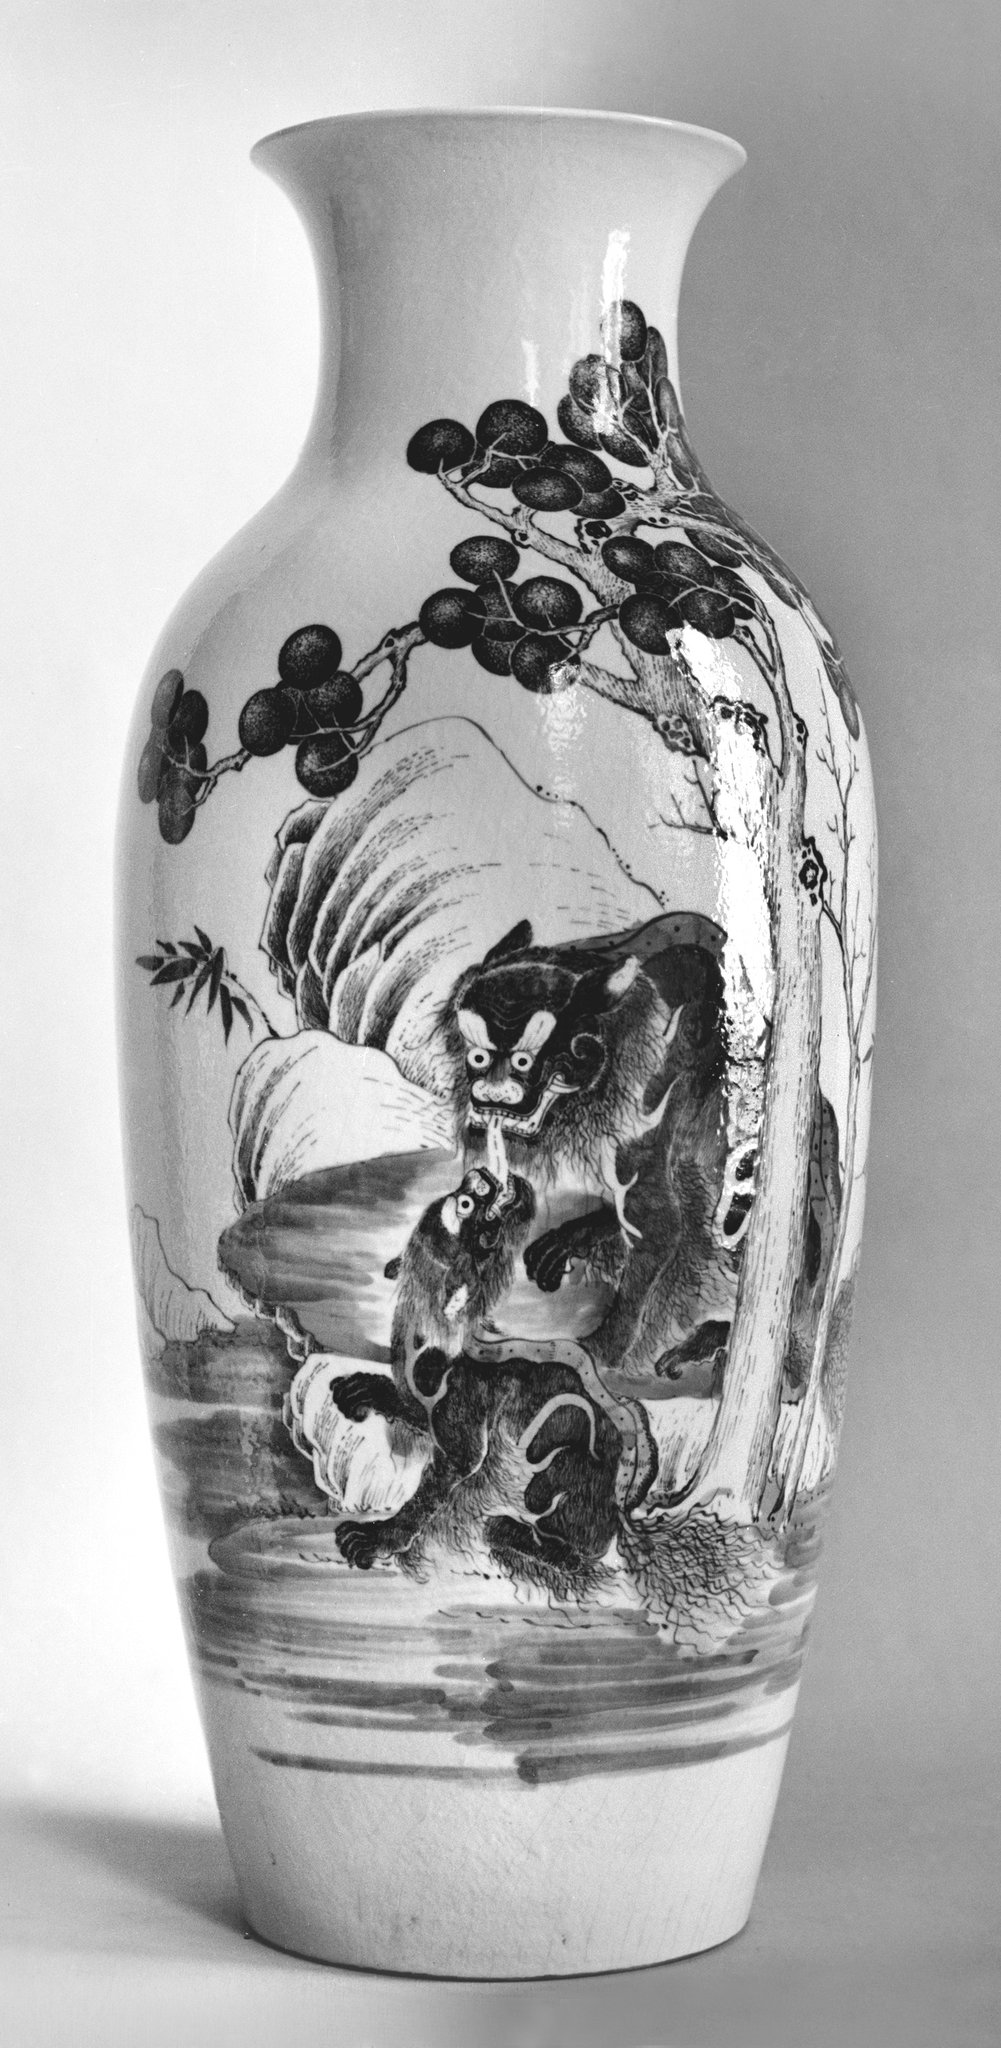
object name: vase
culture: chinese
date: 1735-1795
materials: porcelain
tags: animals,fruit,trees